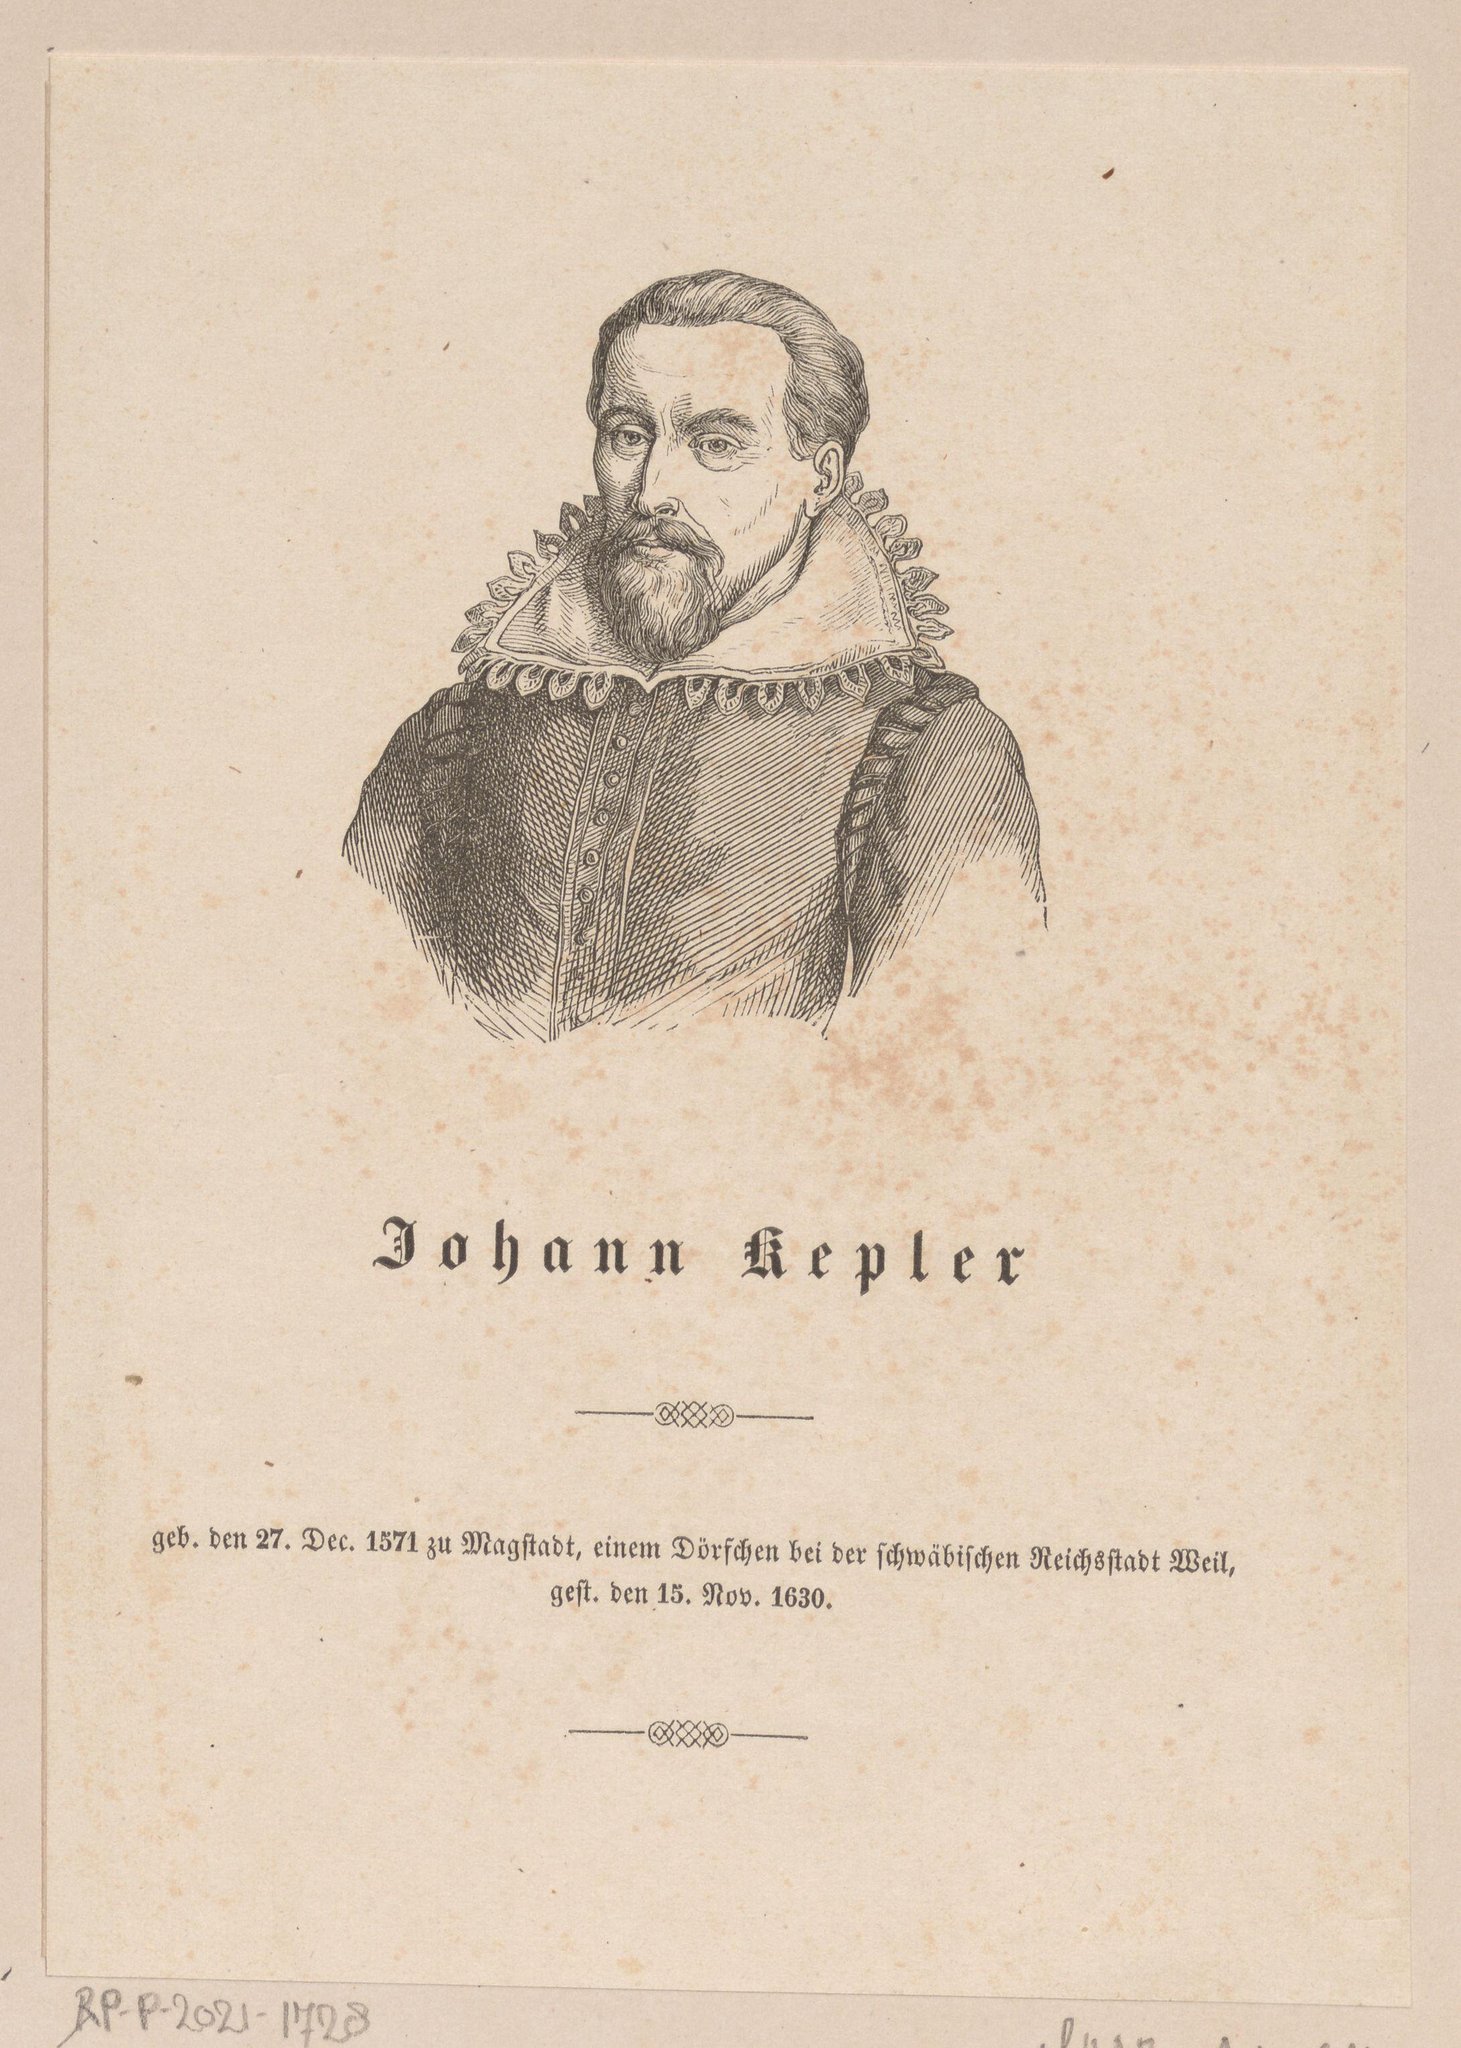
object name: photomechanical print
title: Portret van Johannes Kepler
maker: Anonymous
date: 1800-1899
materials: paper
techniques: letterpress printing, printing block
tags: historical persons